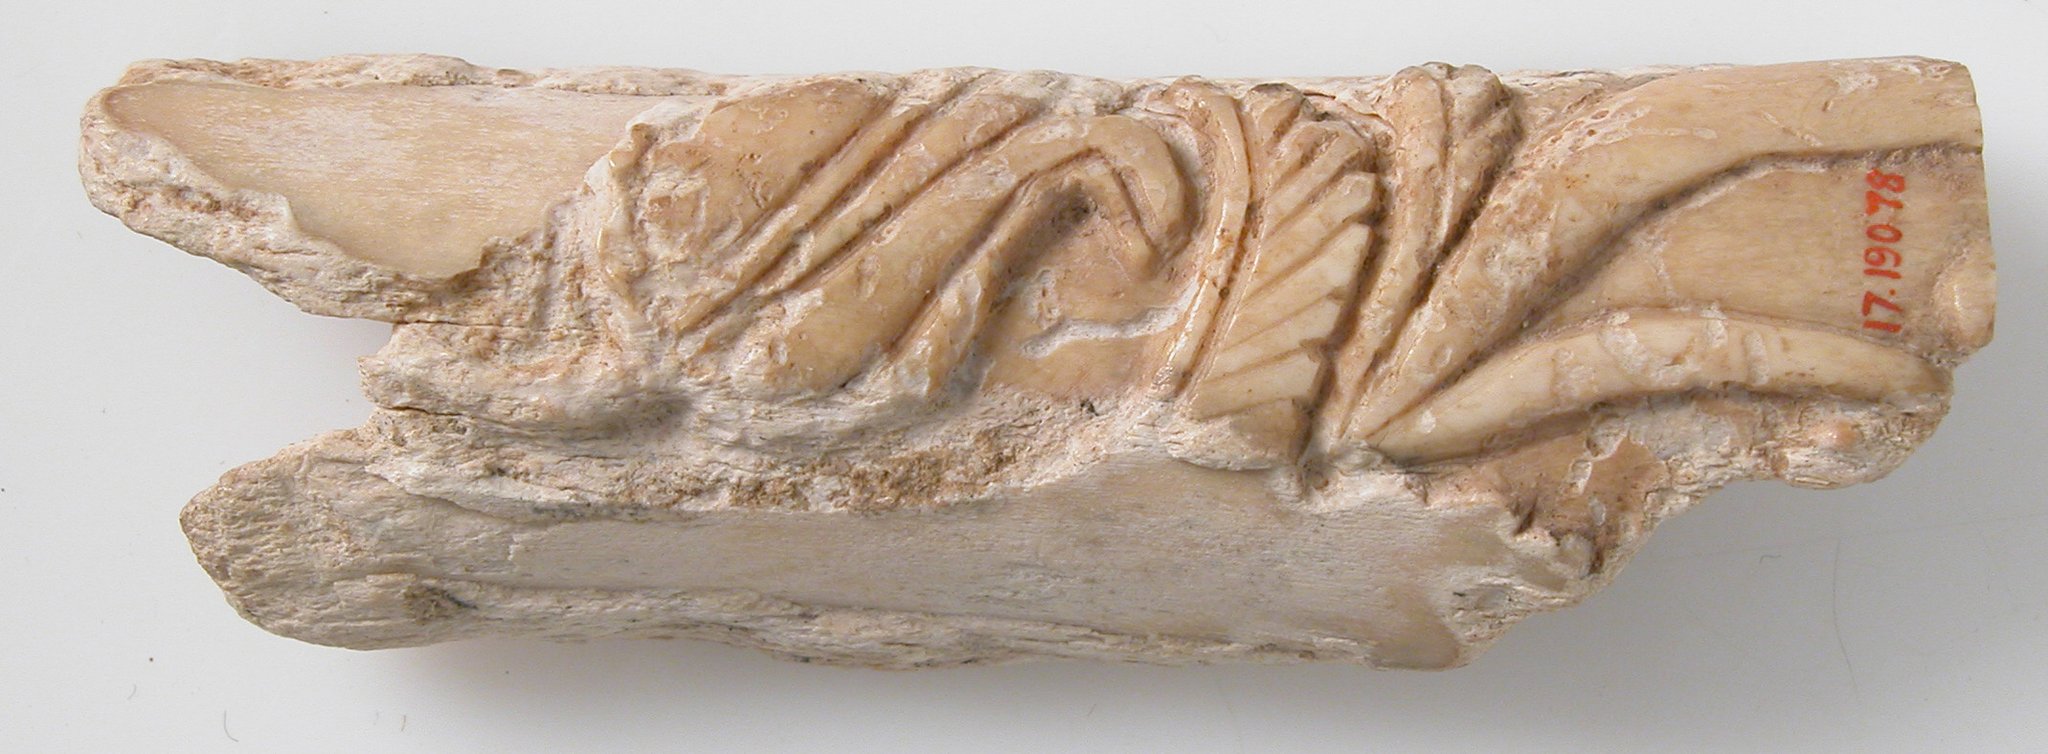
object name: fragment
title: Relief Fragment with Floral Design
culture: coptic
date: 501-700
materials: bone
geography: egypt